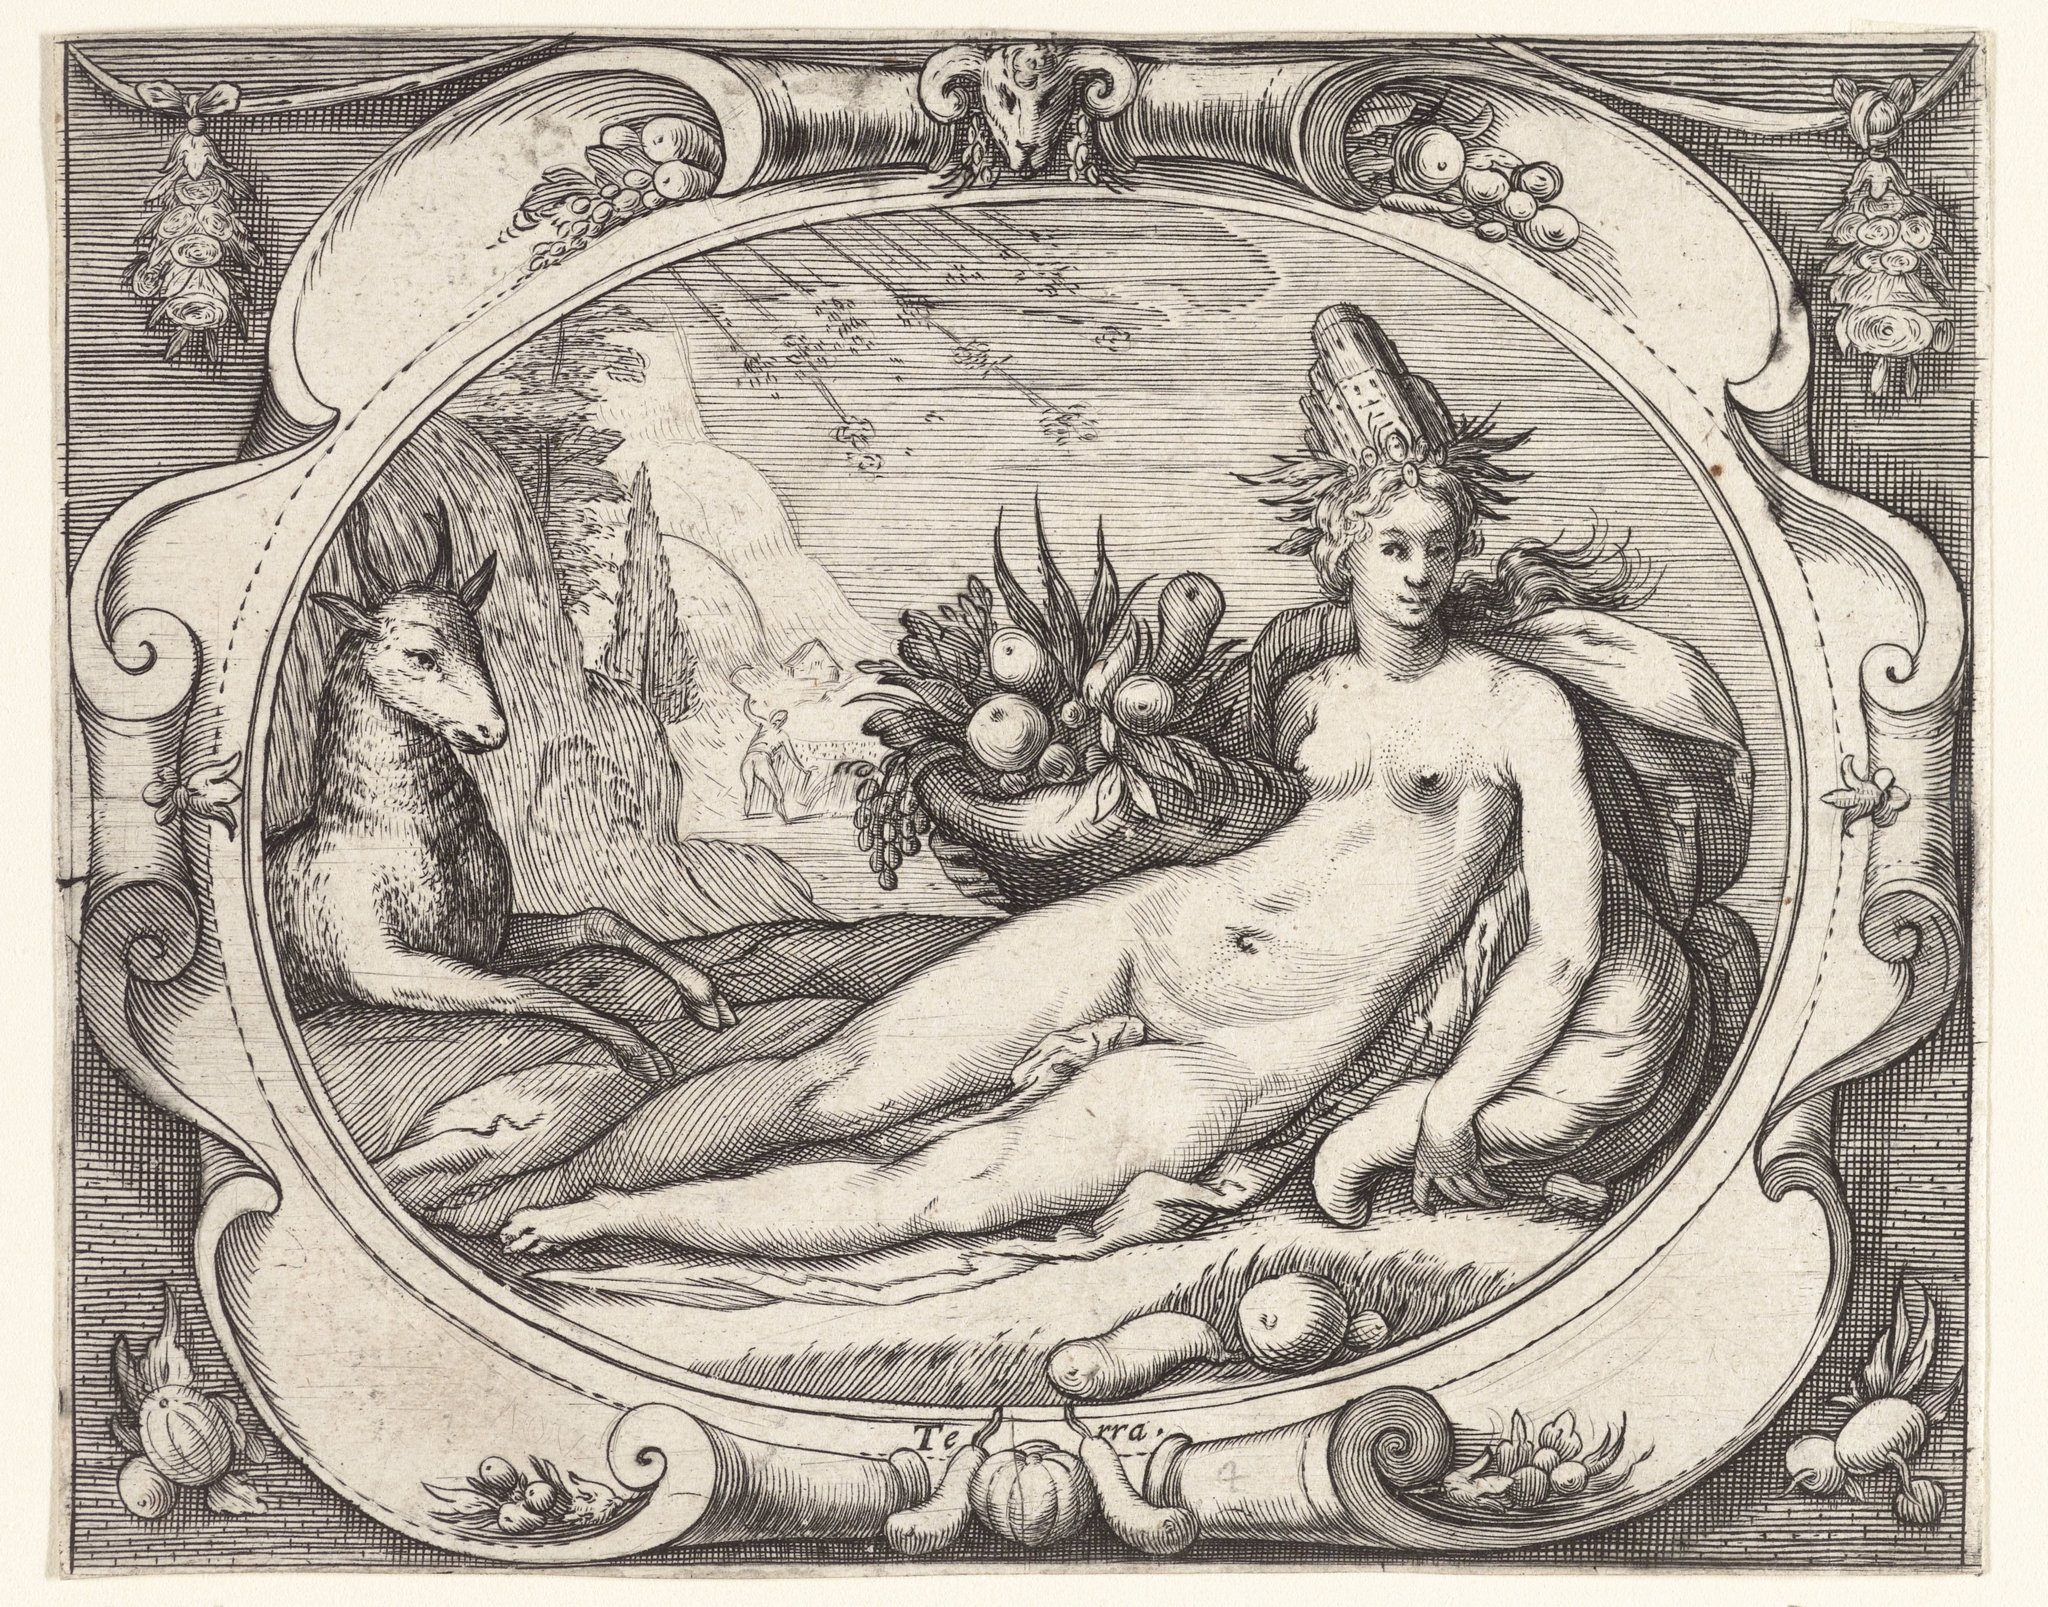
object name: print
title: Aarde (Terra)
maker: jacob matham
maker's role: draughtsman, print maker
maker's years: 1571-1631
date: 1606-1610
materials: paper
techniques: engraving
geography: haarlem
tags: earth (one of the four elements)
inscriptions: collector's mark: Lugt 2228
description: De personificatie van het element aarde: een liggend vrouwelijk naakt in een landschap met een hoorn des overvloeds en naast haar een hert. Vierde prent uit een serie van de vier elementen.